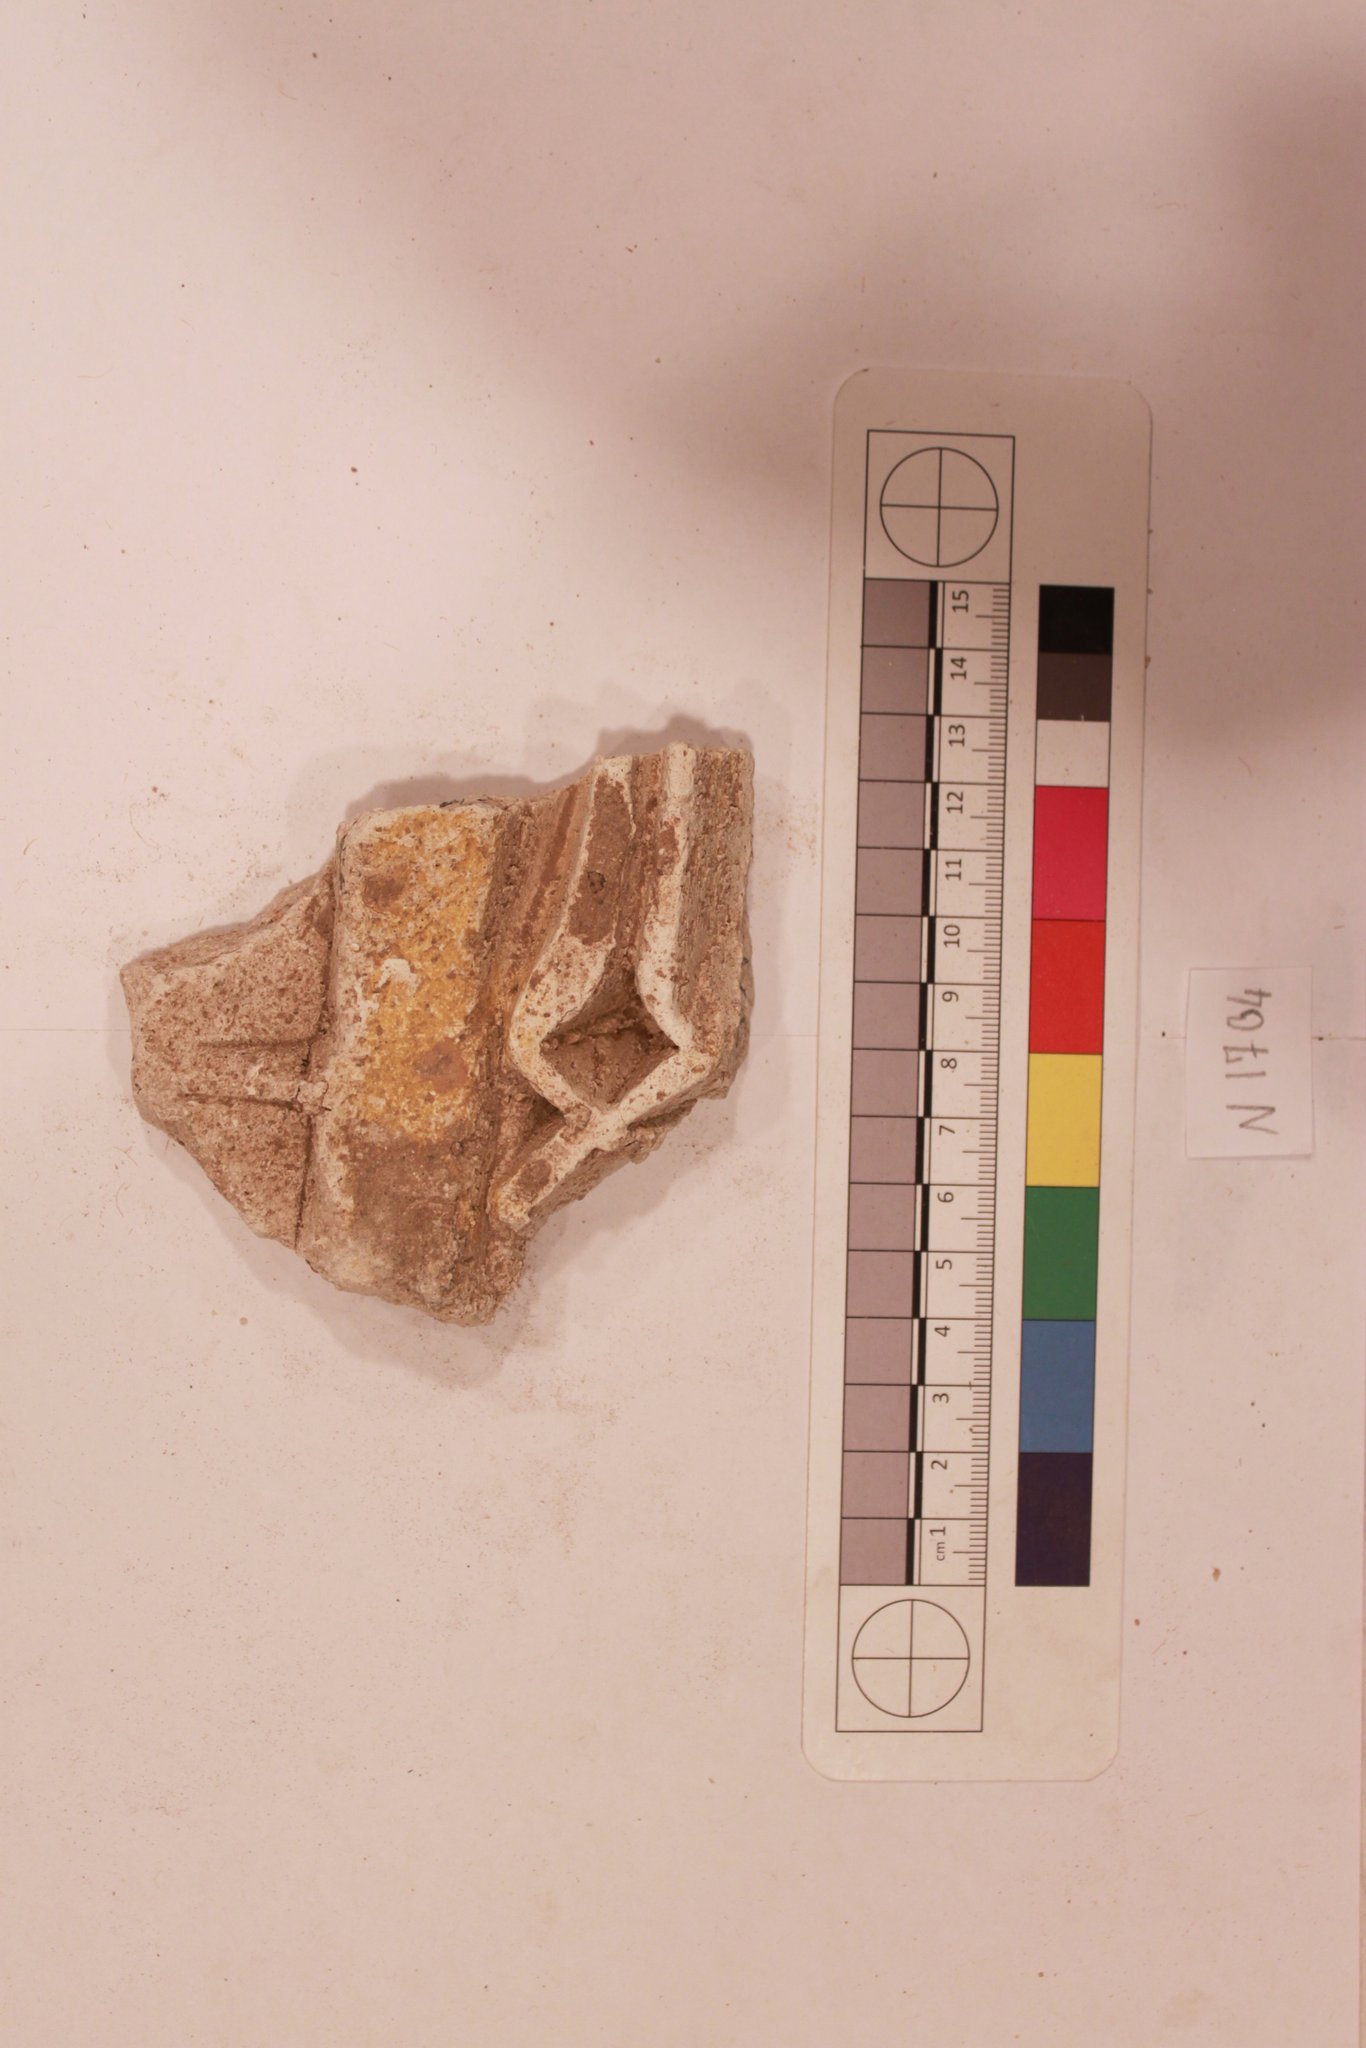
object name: fragment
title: Stucco Fragment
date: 701-1200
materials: plaster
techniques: carving, painting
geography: iran